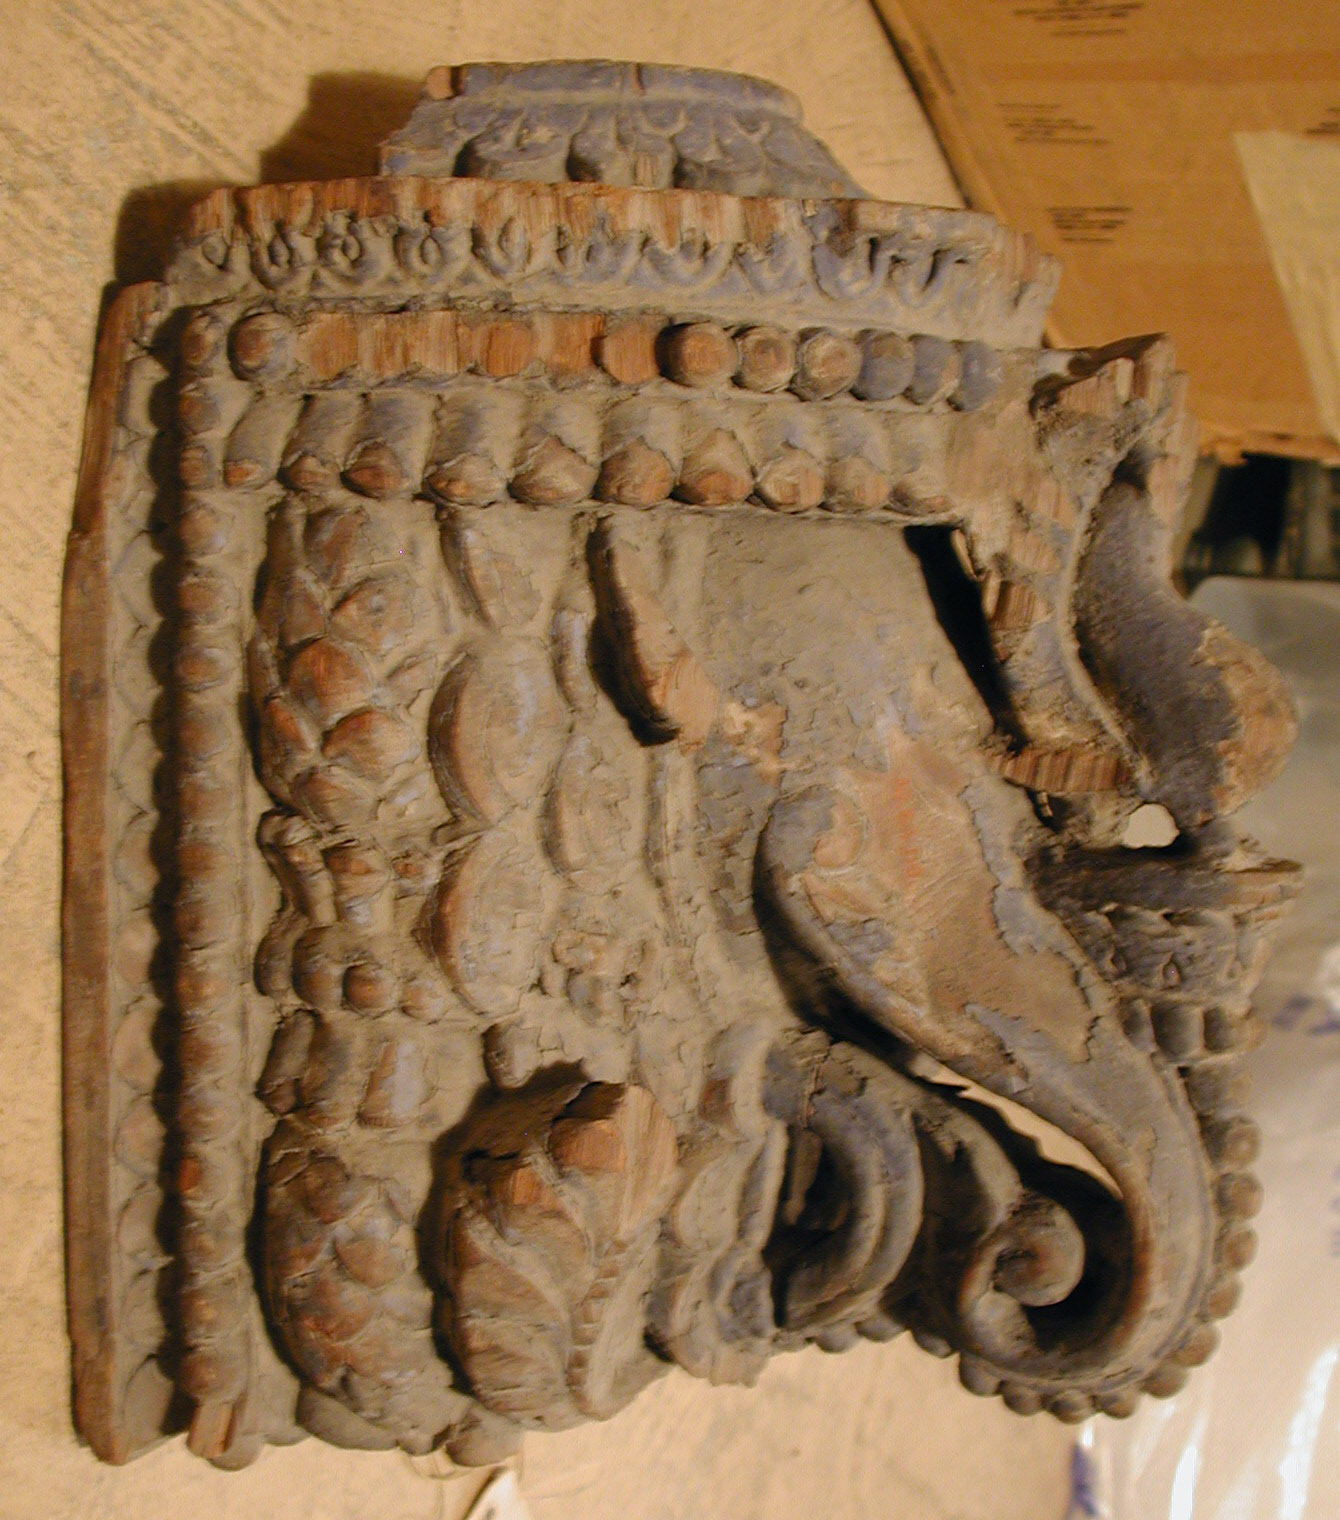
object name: bracket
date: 1501-1700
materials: wood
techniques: carving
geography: india